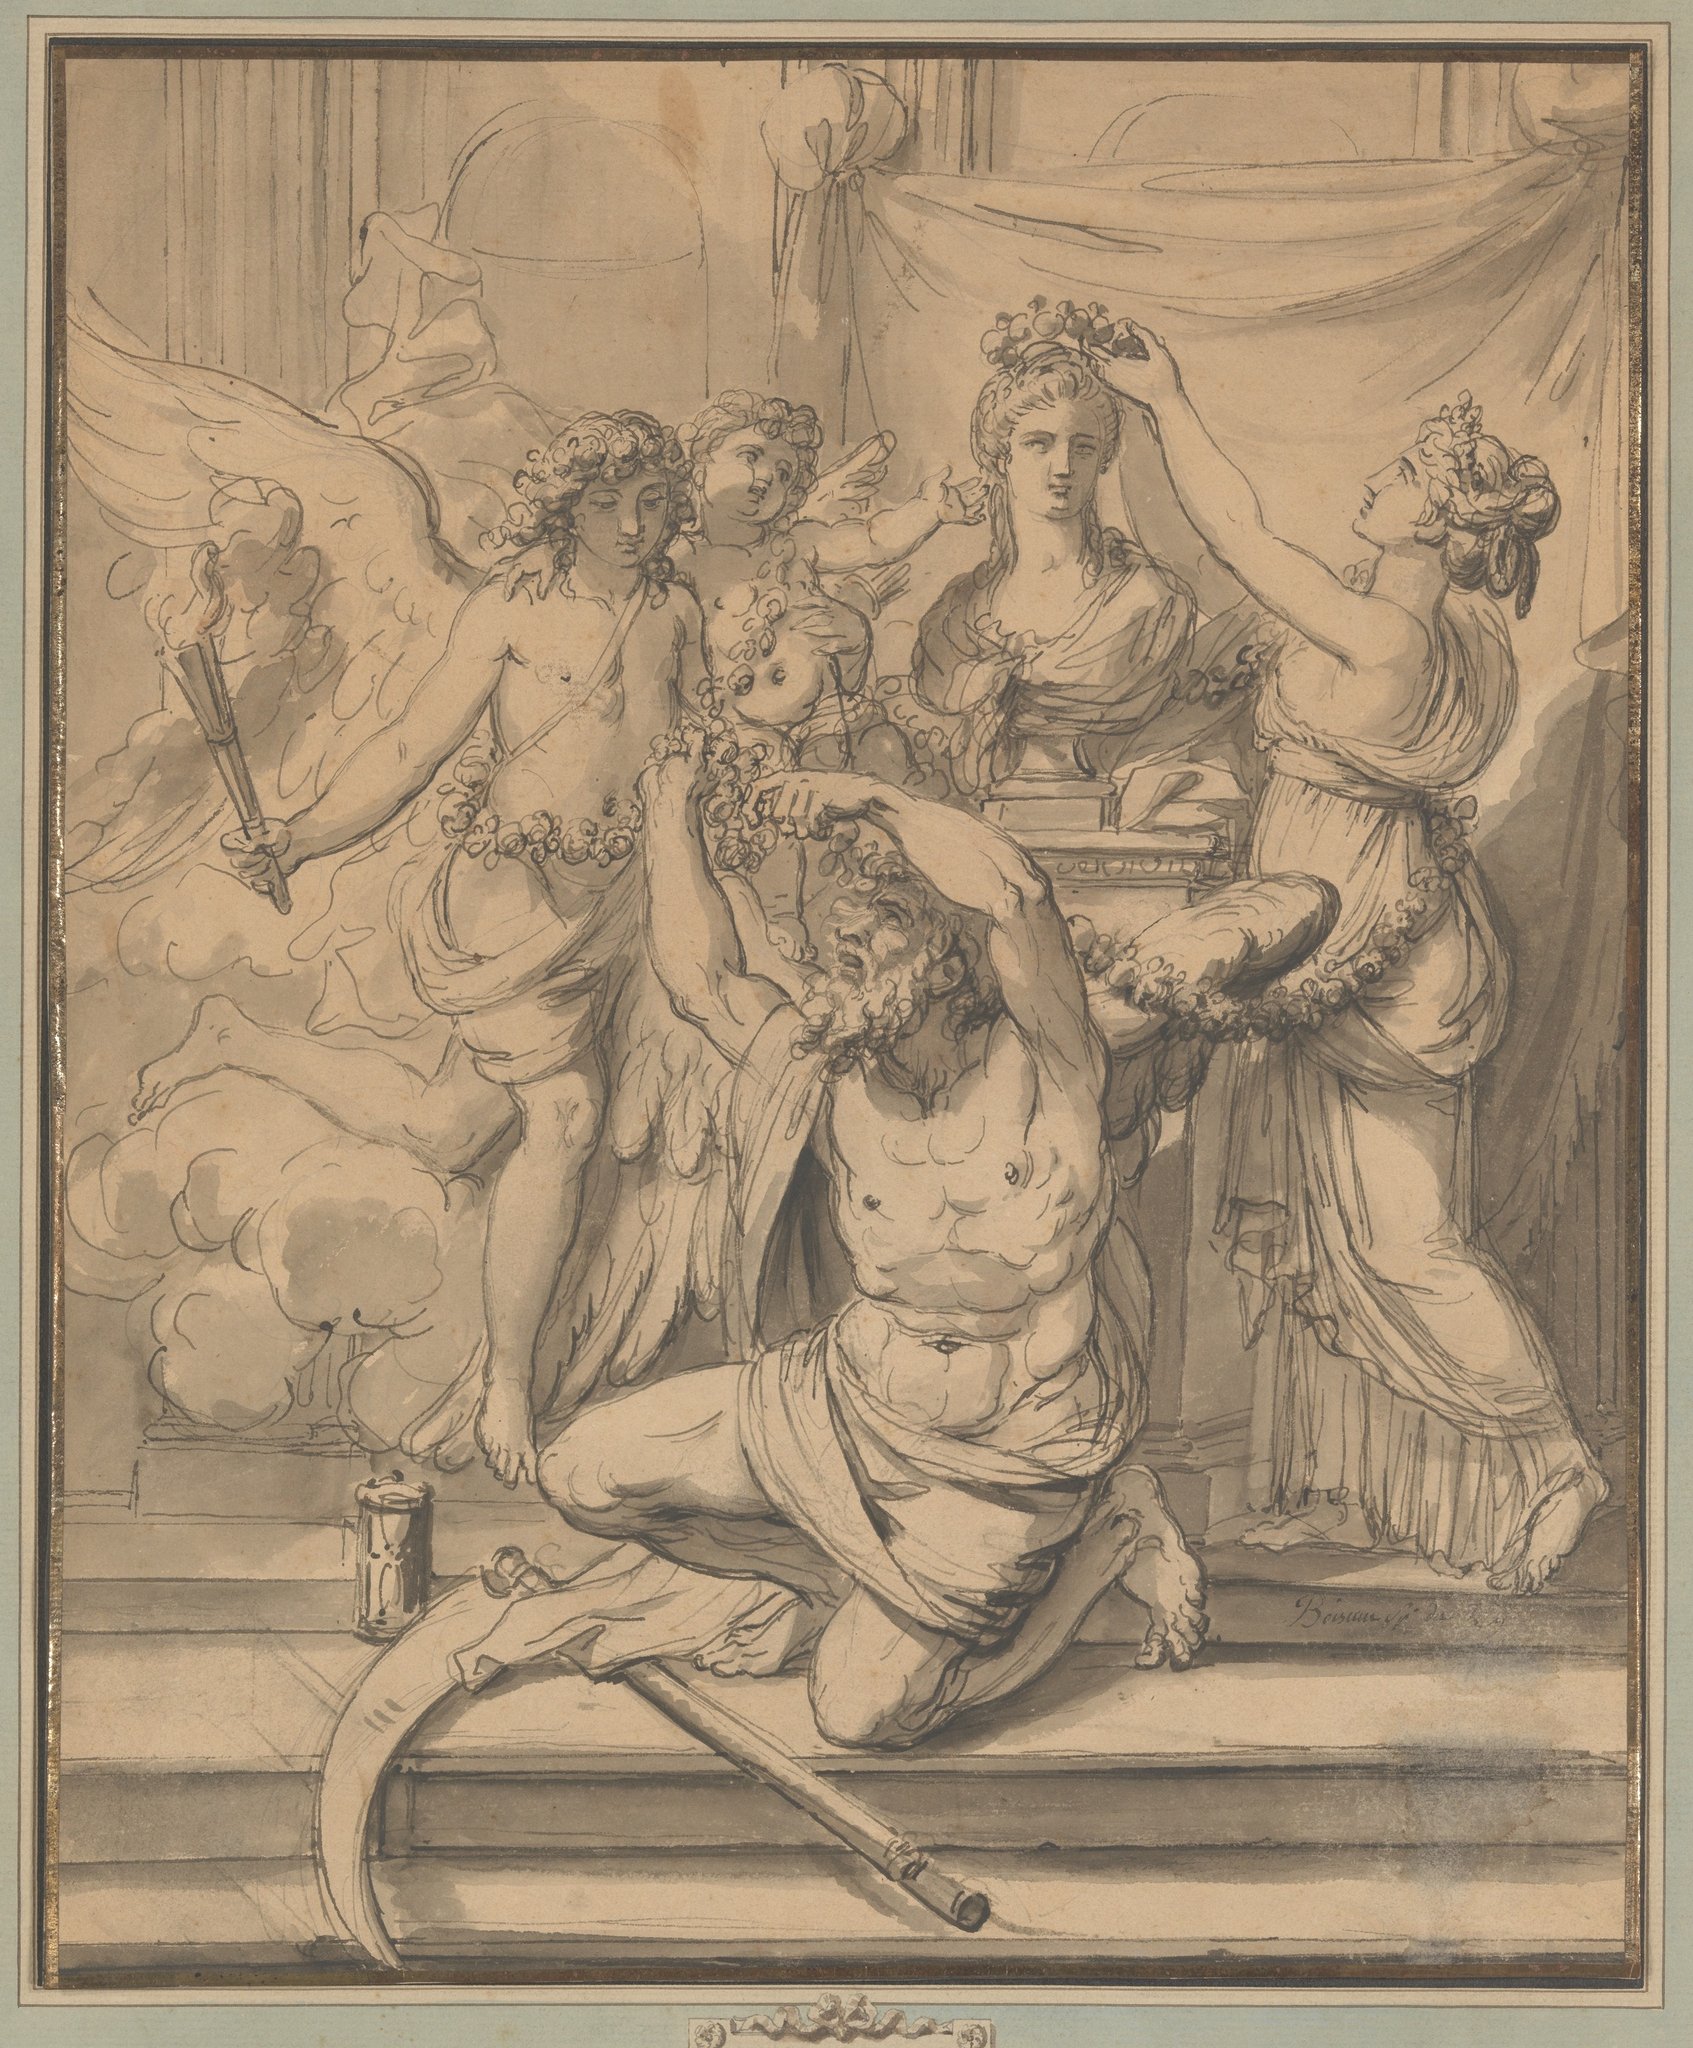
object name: drawing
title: Time Banished by Truth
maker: jean jacques de boissieu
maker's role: artist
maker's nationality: french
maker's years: 1736-1810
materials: chalk, ink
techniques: brush, pen, wash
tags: diadems,weapons,men,women